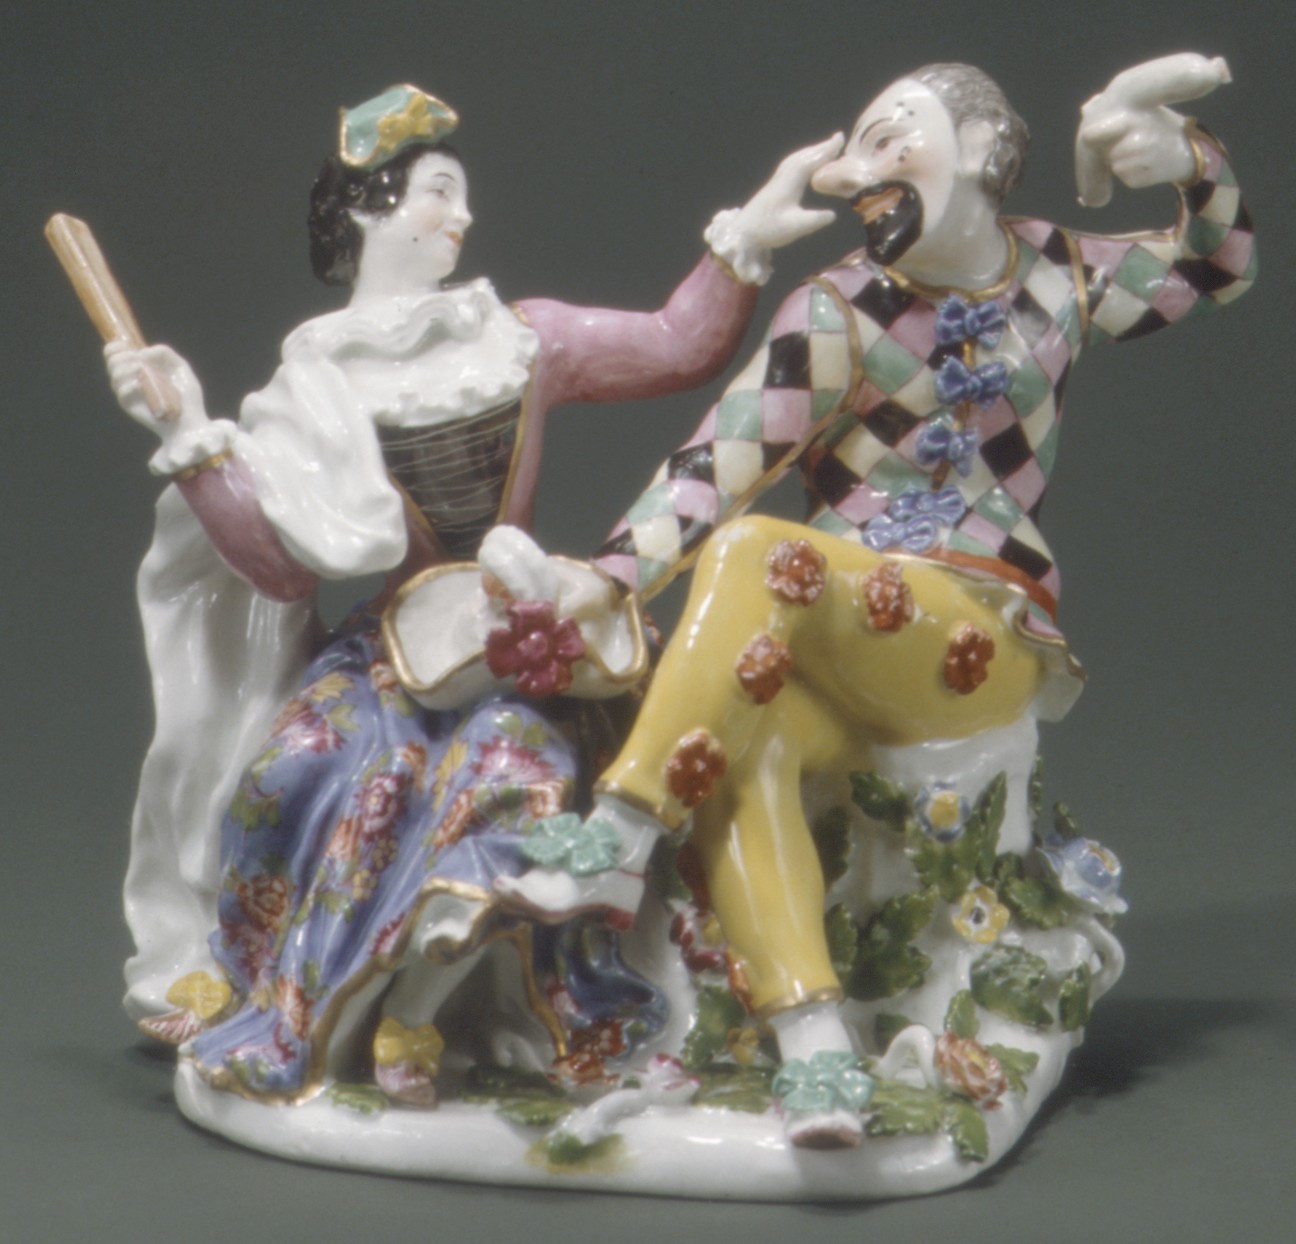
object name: group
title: Hanswurst and Columbine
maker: meissen manufactory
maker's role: manufactory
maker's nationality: german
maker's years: 1710-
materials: hard paste porcelain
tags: men,women,flowers,leaves